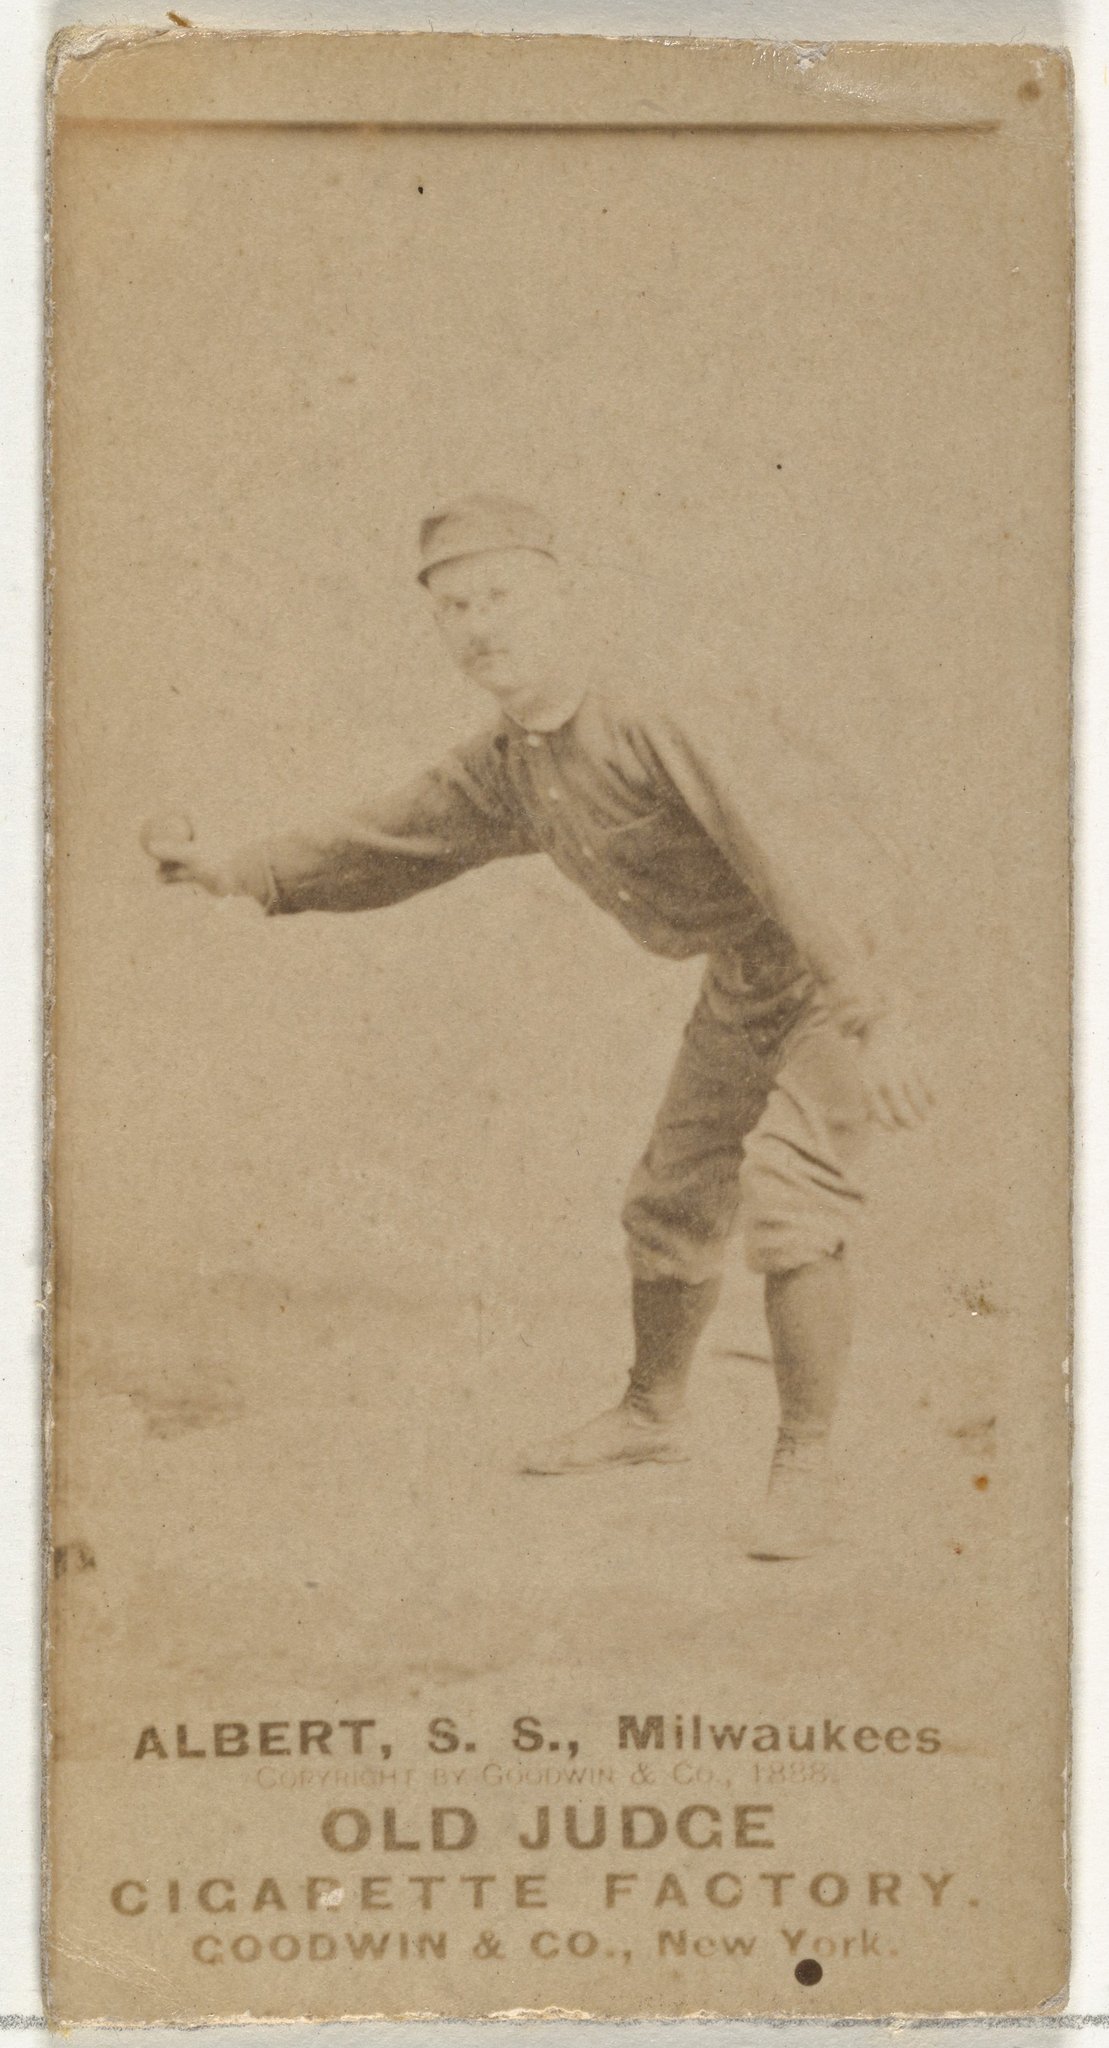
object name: baseball card, photograph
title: Augustus Peter "Gus" Alberts, Shortstop, Milwaukee, from the Old Judge series (N172) for Old Judge Cigarettes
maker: goodwin & company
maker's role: publisher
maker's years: 1850-1950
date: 1888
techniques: albumen silver print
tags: men,baseball,athletes